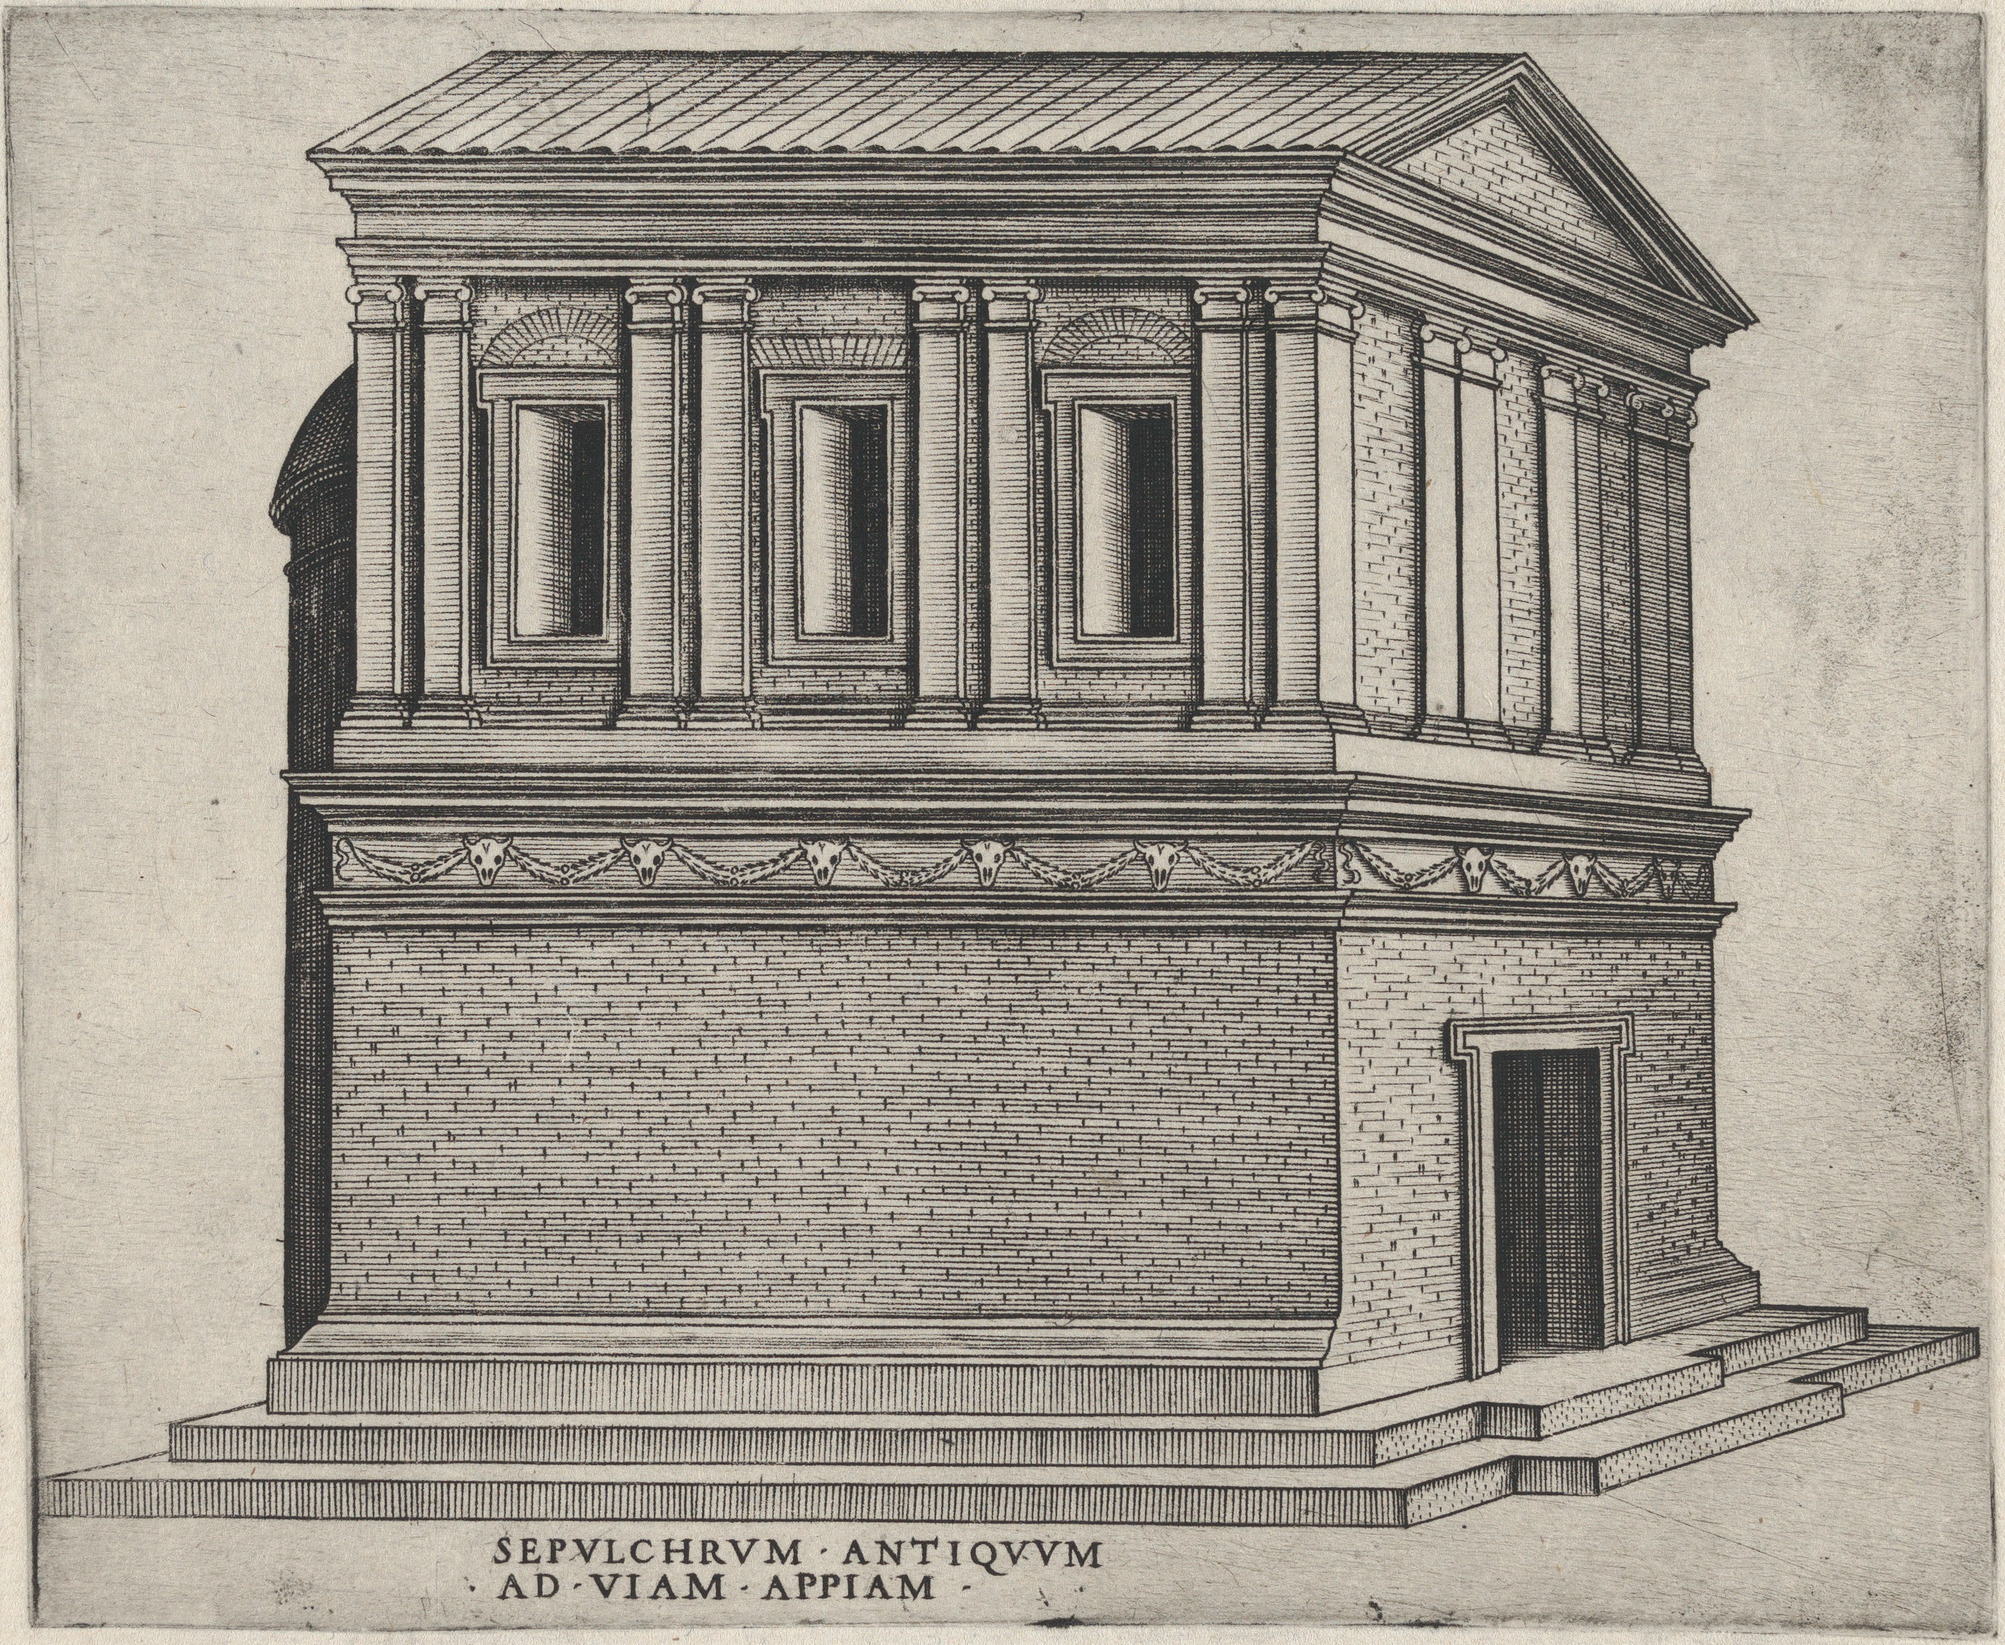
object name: print ornament architecture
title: Sepulchrum Antiquum Ad Viam Appiam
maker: anonymous, italian, 16th century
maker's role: artist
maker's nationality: italian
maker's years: 1500-1600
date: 1550-1560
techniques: engraving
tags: architecture